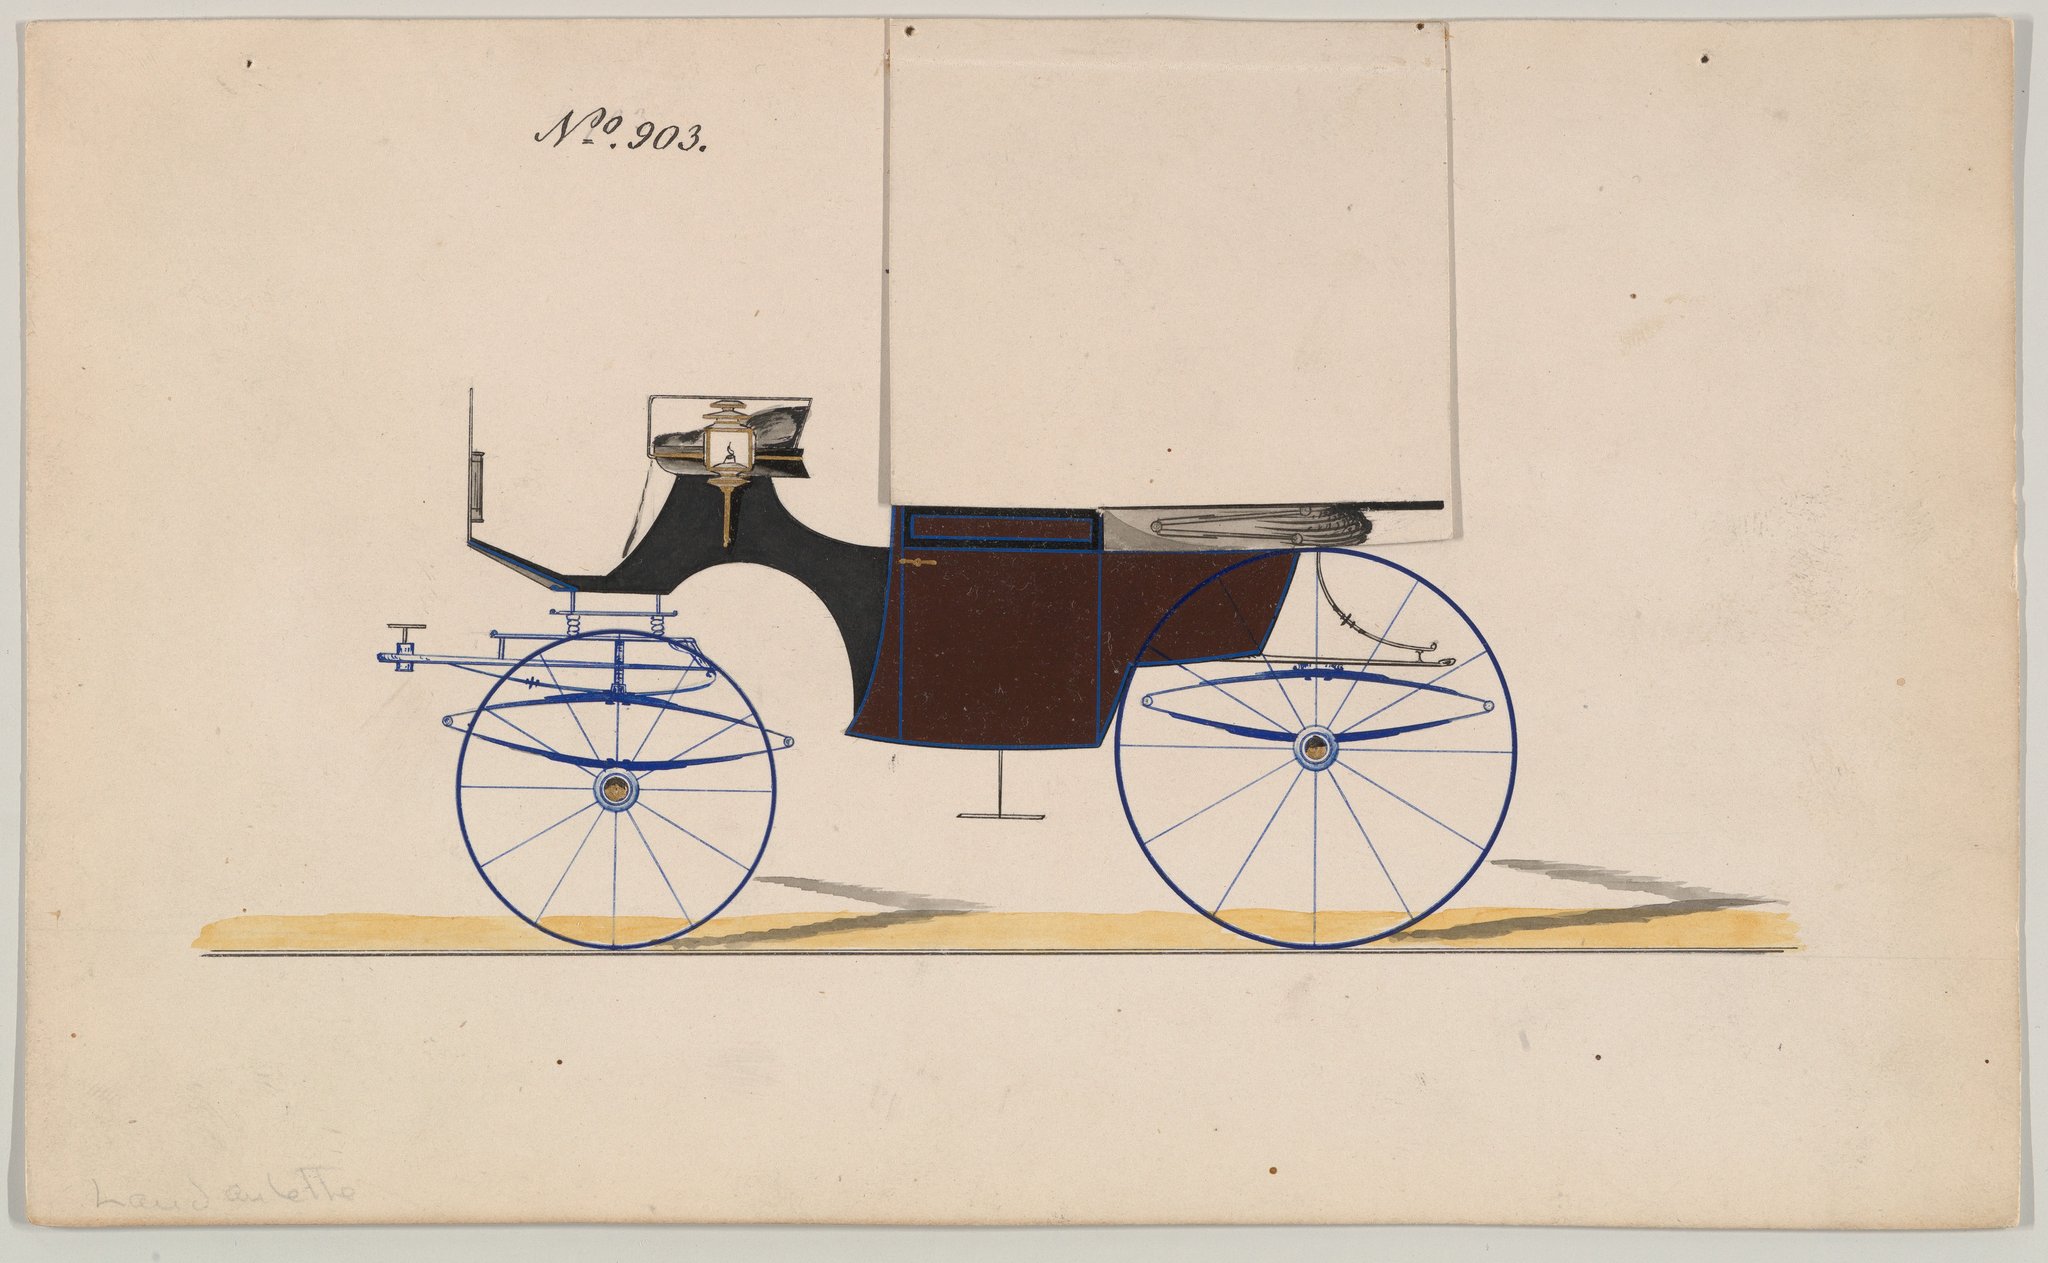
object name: drawing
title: Landaulet #903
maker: brewster & co.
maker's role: manufacturer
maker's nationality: american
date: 1850-1870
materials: gouache, gum arabic, ink, watercolor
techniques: pen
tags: carriages